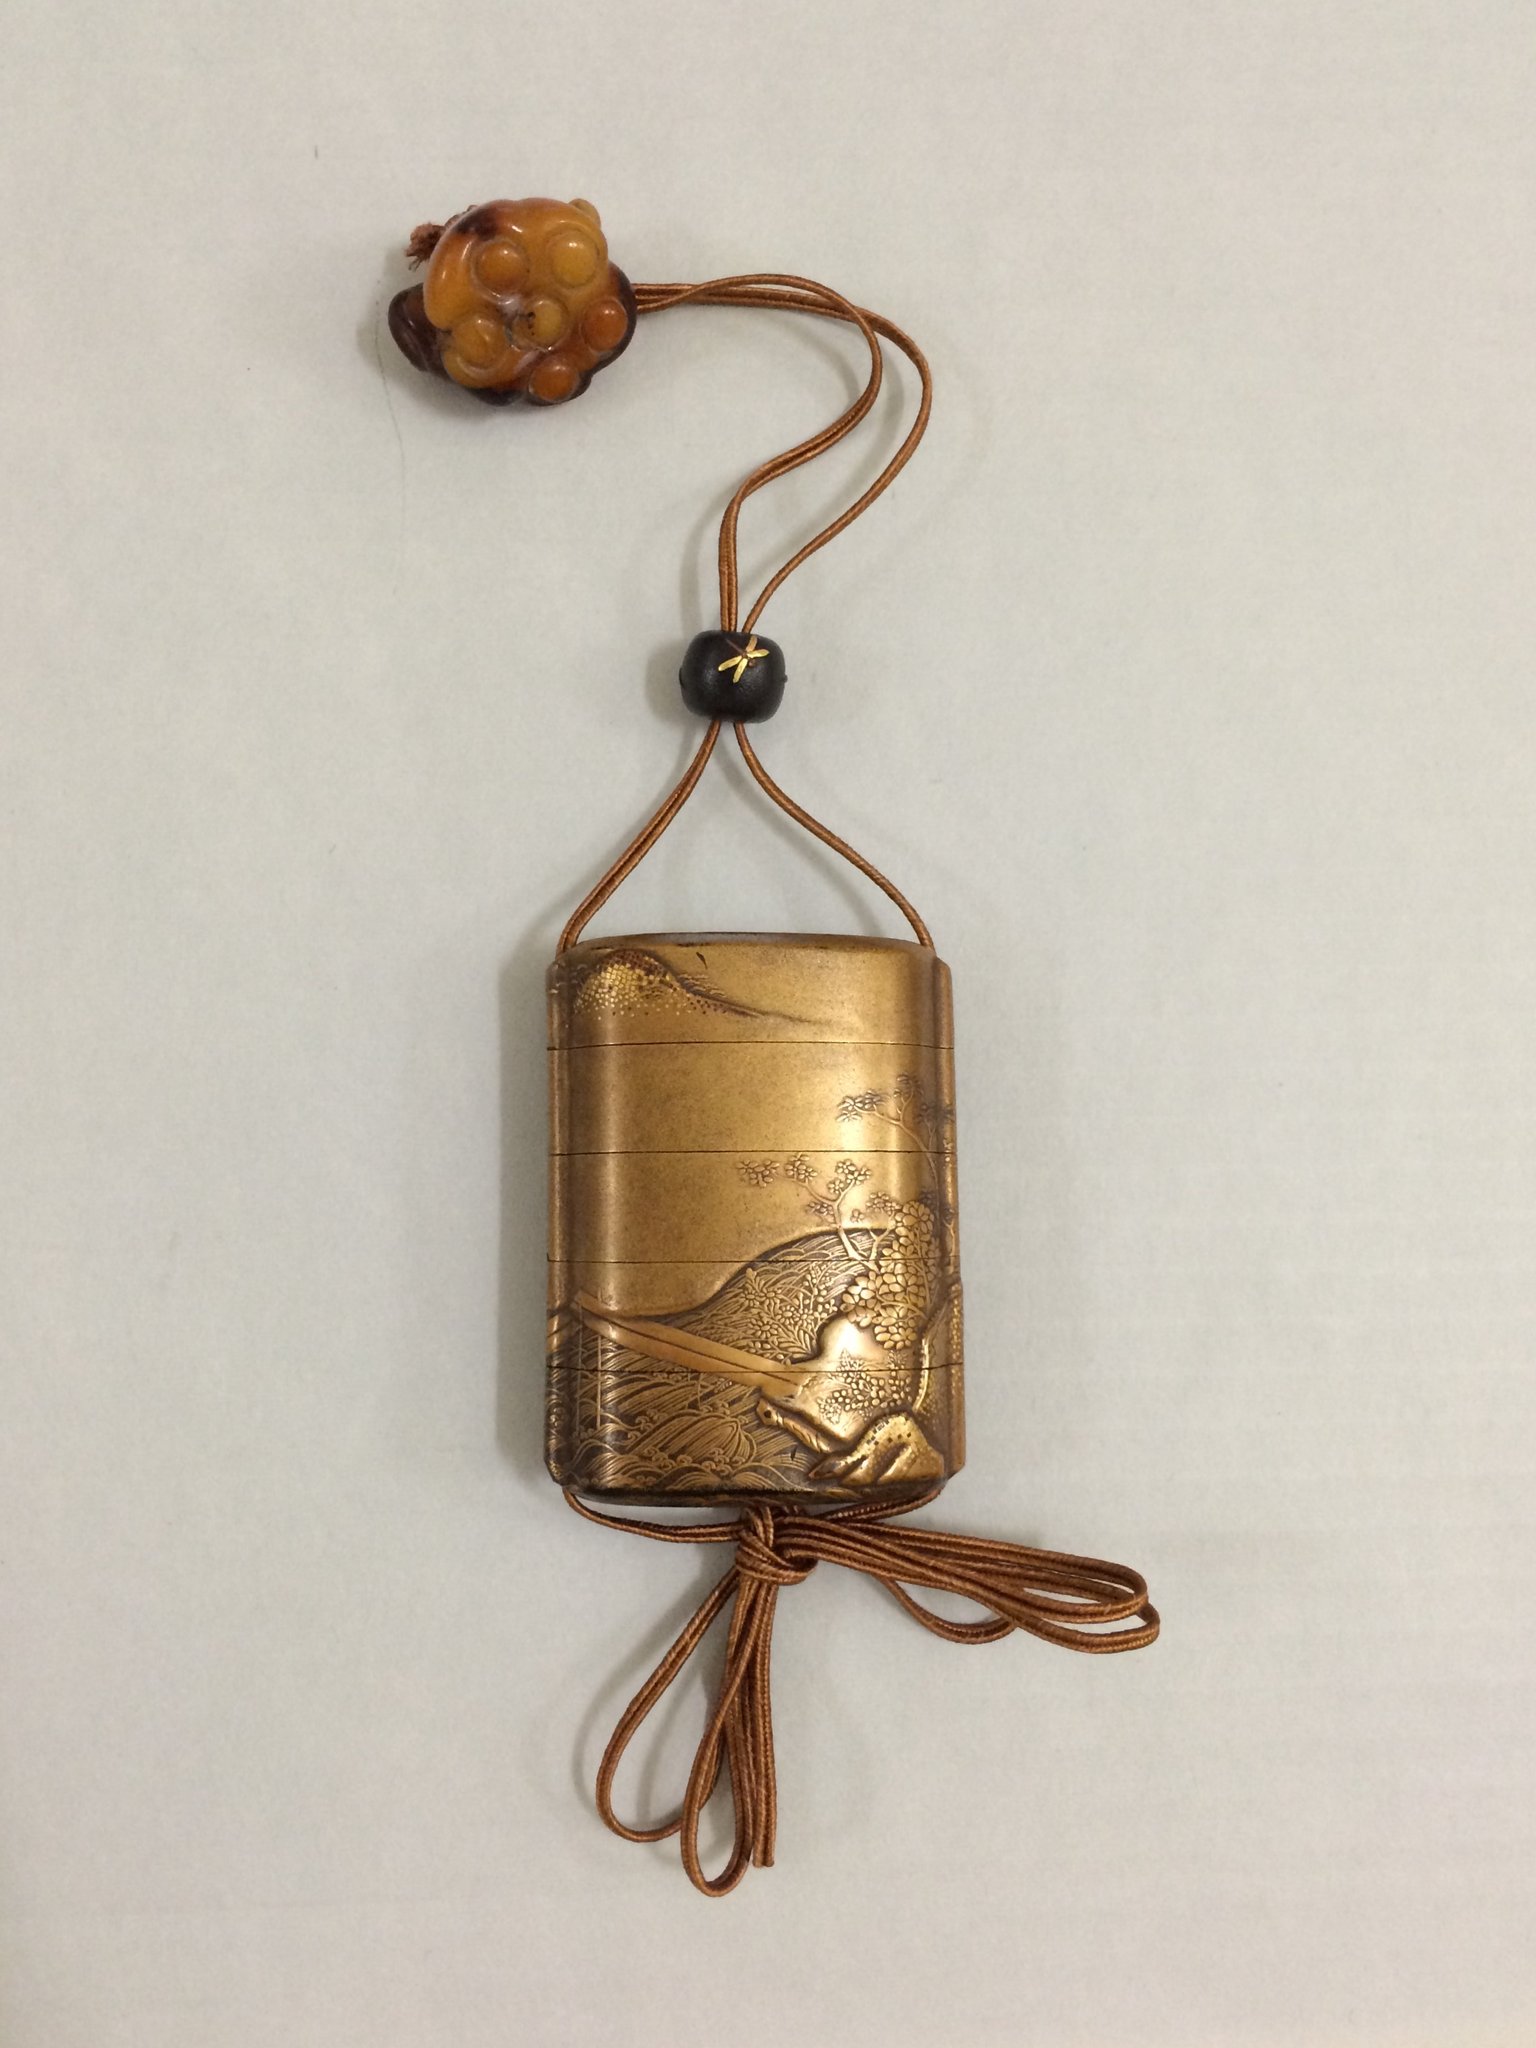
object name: inrō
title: Case (Inrō) with Design of Landscape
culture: japanese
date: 1701-1800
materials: gold, gold foil, lacquer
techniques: cutting, maki